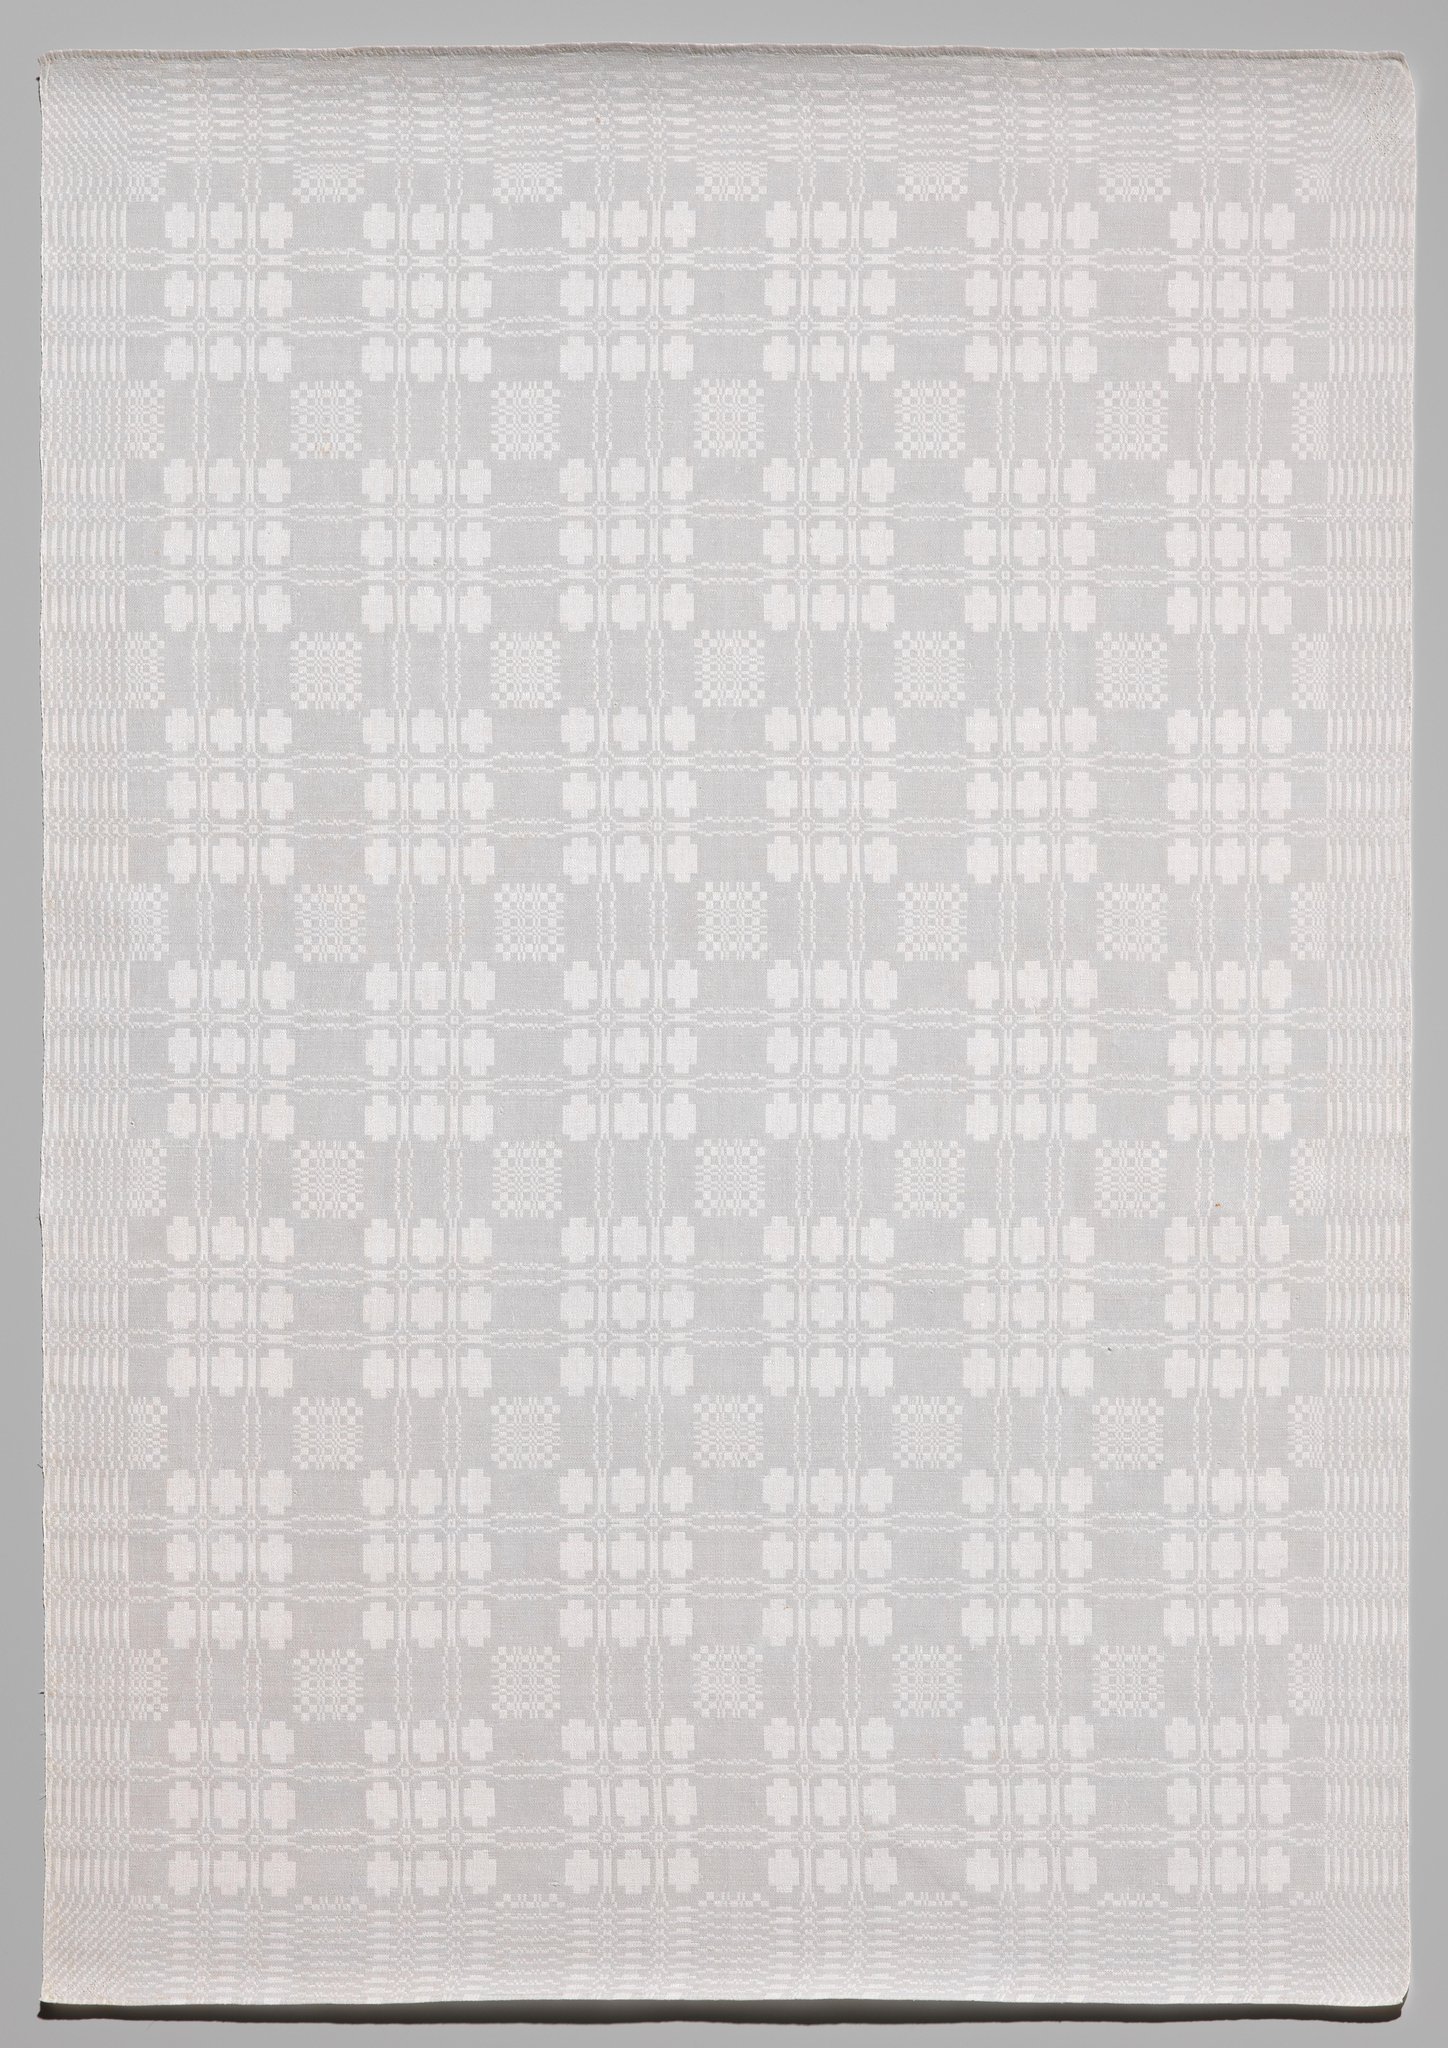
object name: napkin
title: Servet van linnen met pellenpatroon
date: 1745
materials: linen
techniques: peeled fabric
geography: northern netherlands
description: wit linnen servet met pellen patroon, merk kroon BG 5 en 1745